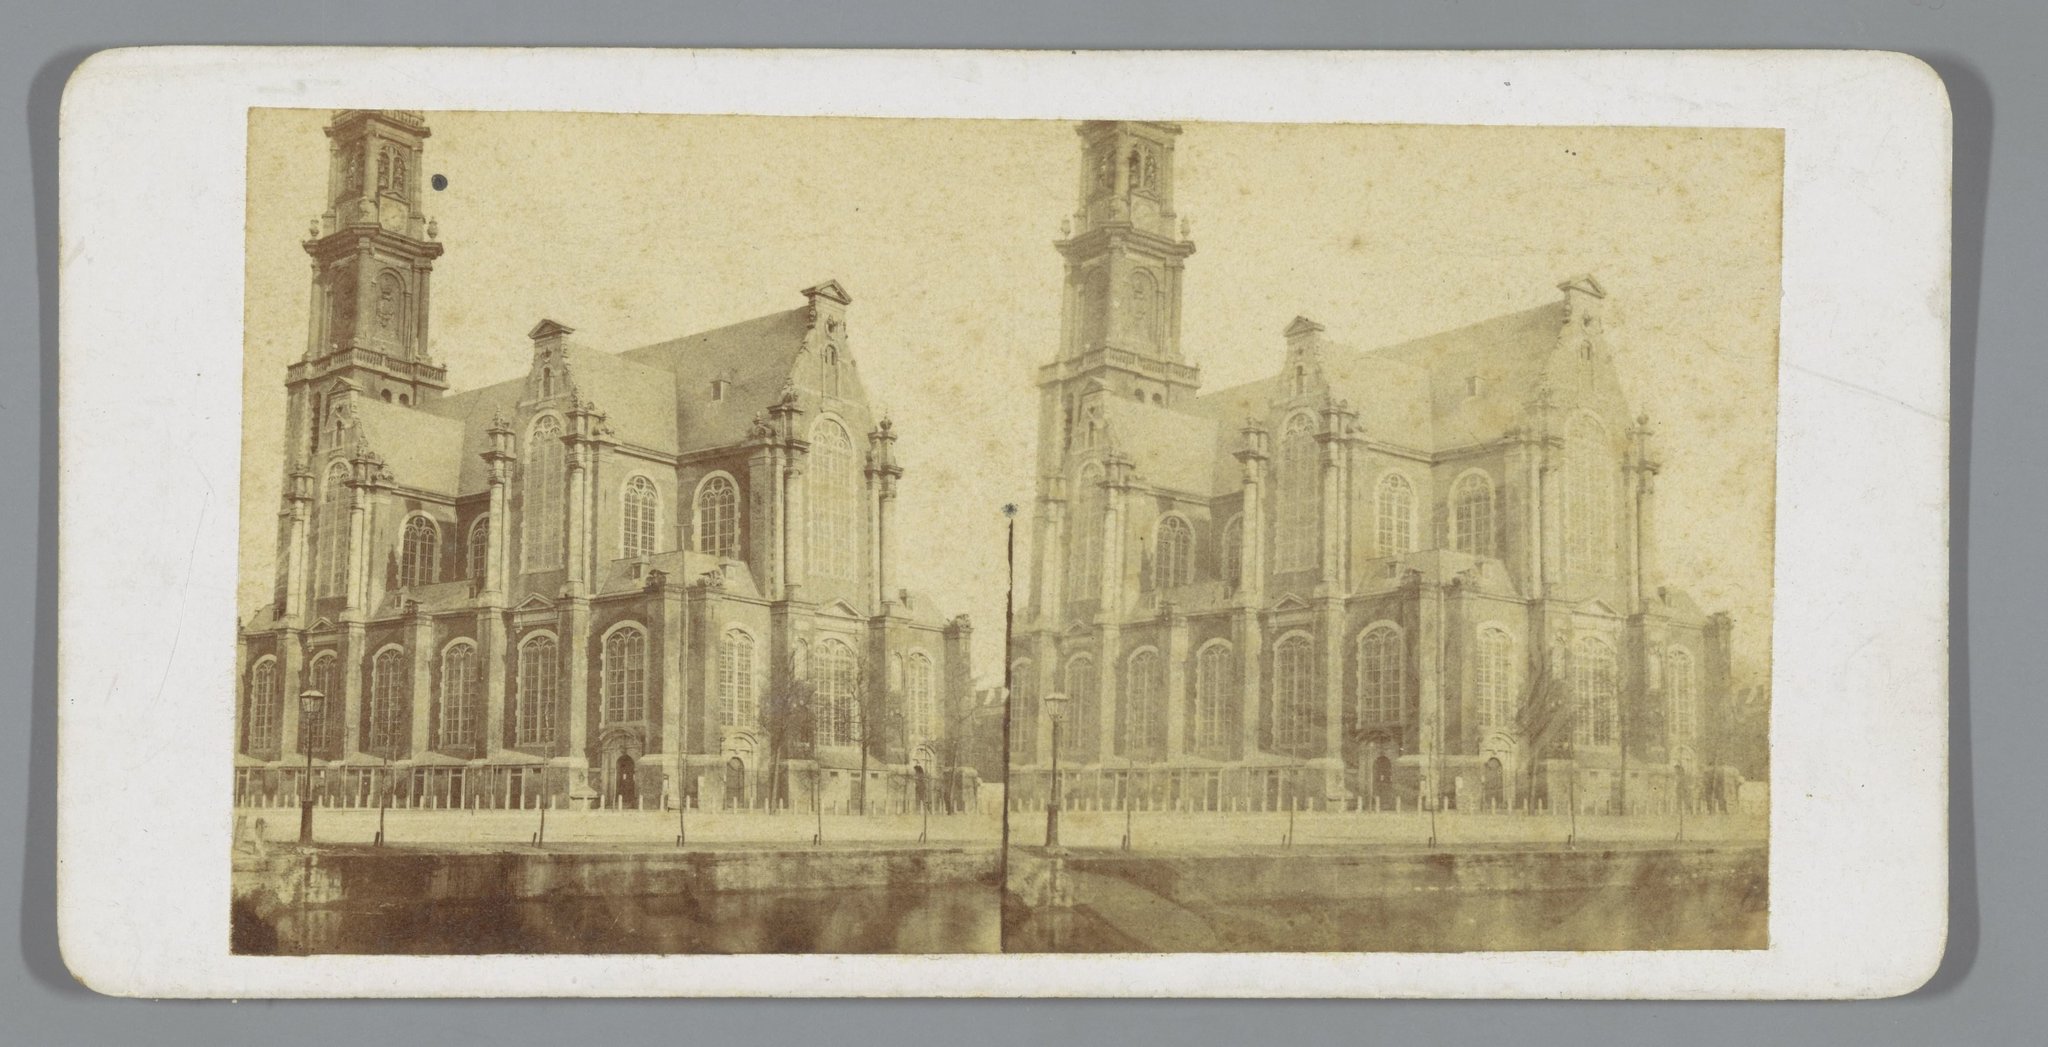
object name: stereograph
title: Gezicht op de Westerkerk vanaf de Keizersgracht, Amsterdam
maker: Anonymous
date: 1857-1860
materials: cardboard, paper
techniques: albumen print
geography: amsterdam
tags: church (exterior)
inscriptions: inscription: ‘Amsterdam/ Westerkerk/ CT/ Westerkerk/ Amsterdam/ 28’